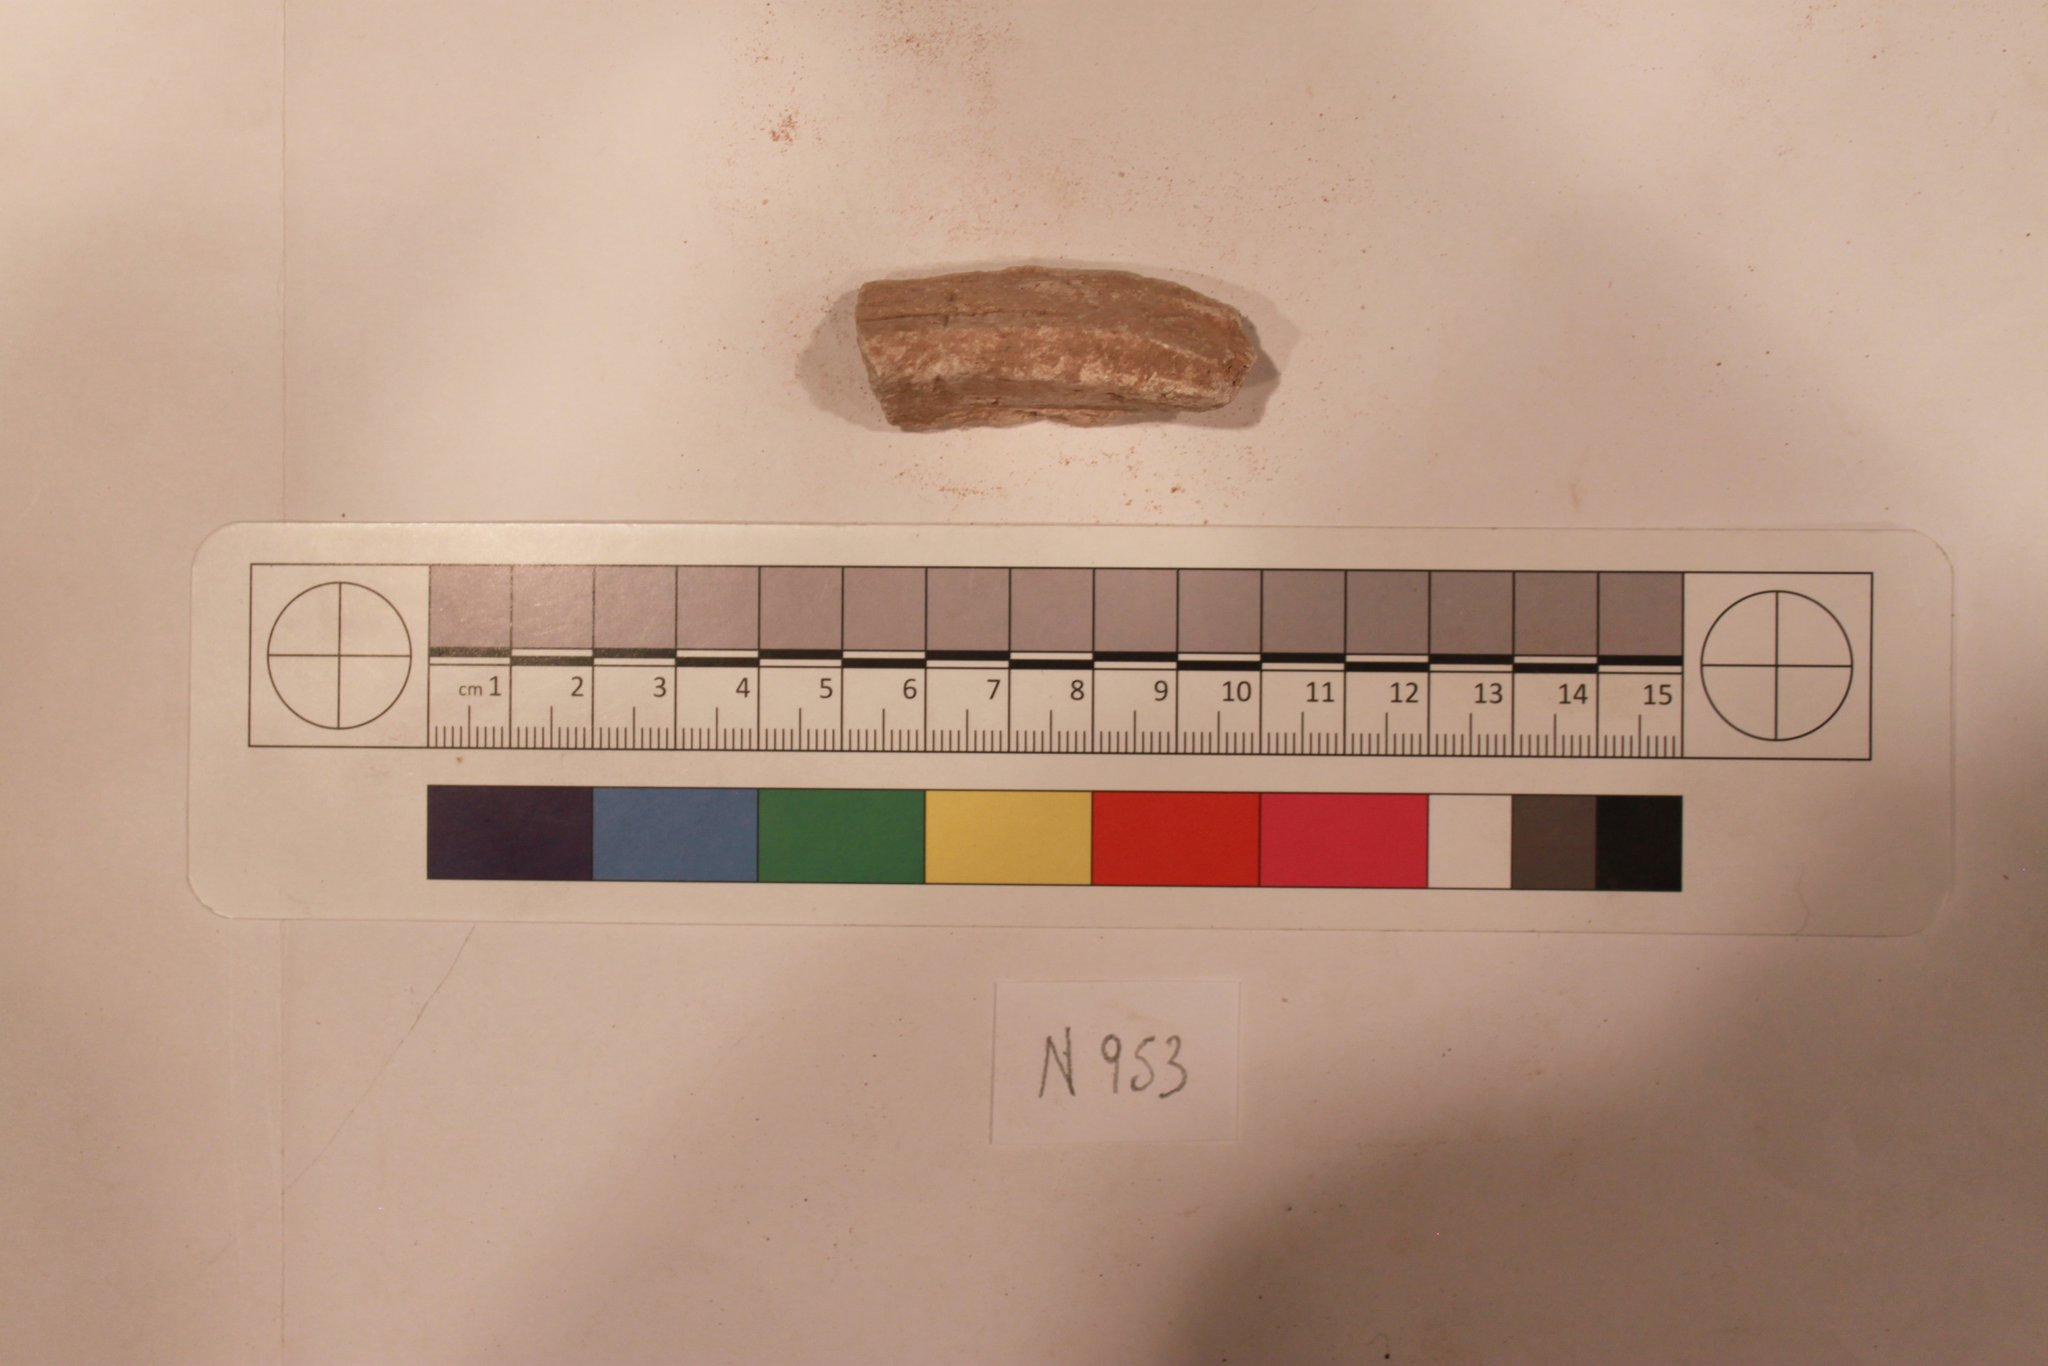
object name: fragment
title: Stucco Fragment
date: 701-1200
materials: plaster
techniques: carving, painting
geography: iran